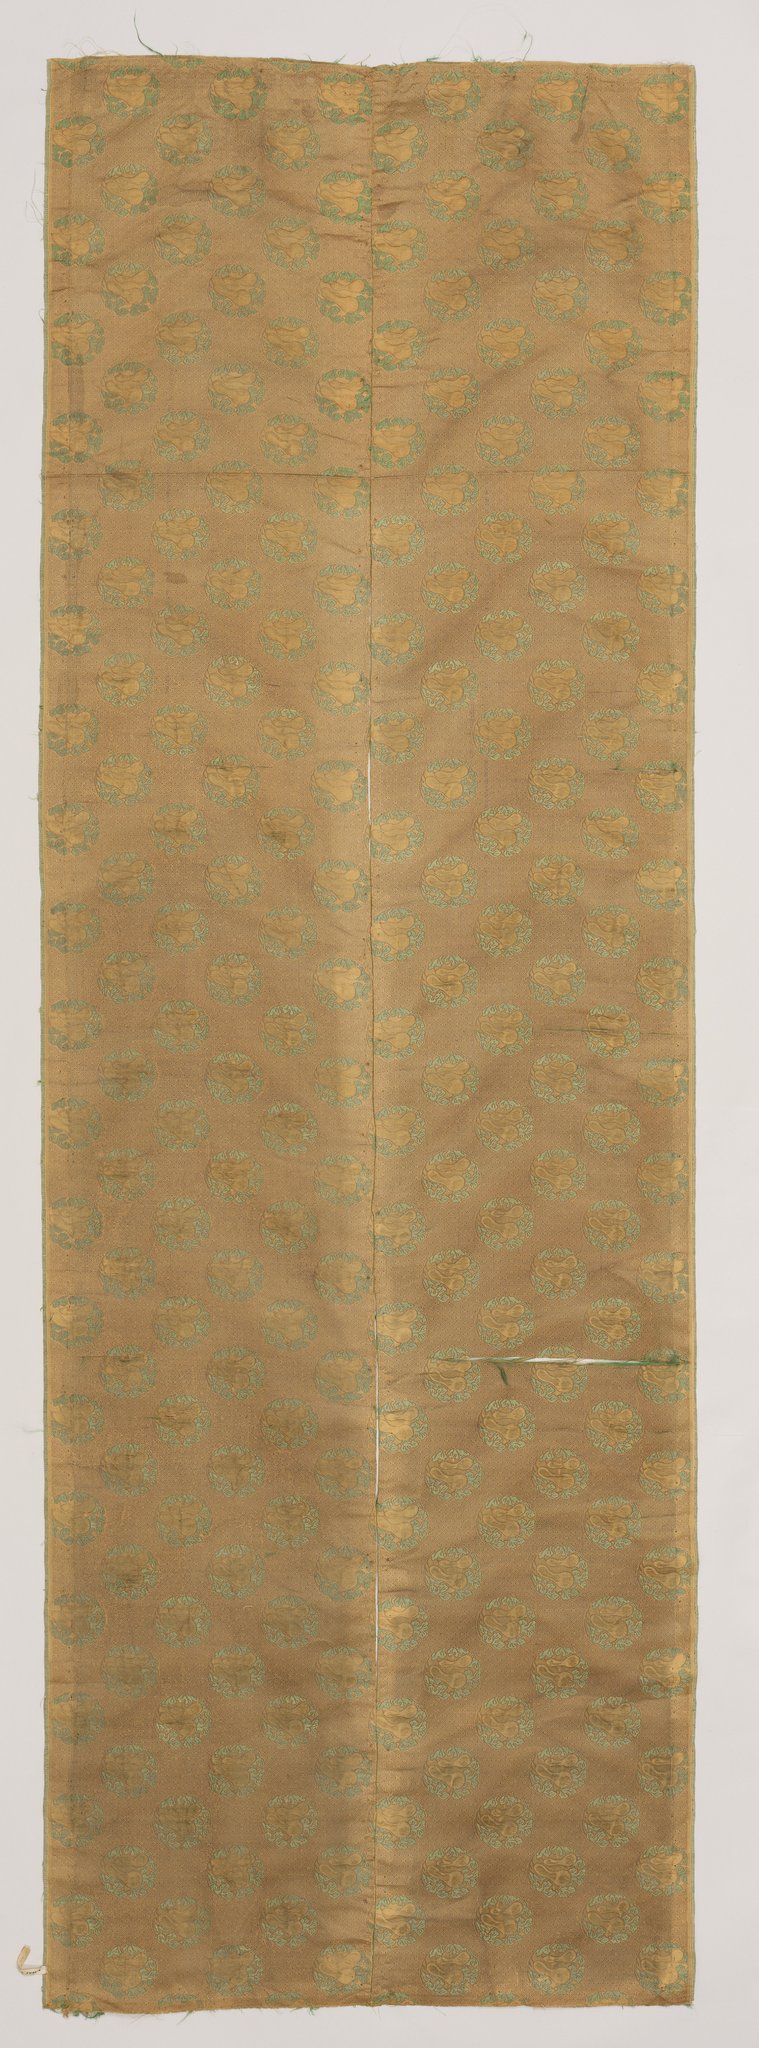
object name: piece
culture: japanese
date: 1701-1800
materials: silk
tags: gourds